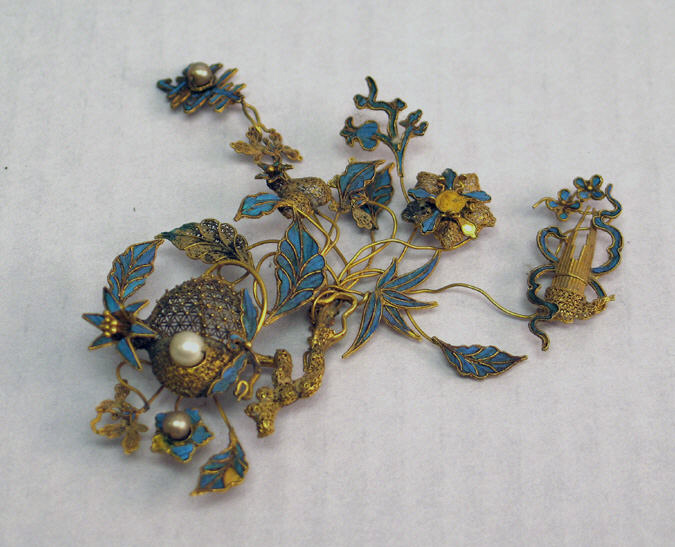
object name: headdress fragment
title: Fragment of Headdress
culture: chinese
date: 1644-1911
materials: feather, gold, pearl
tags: flowers